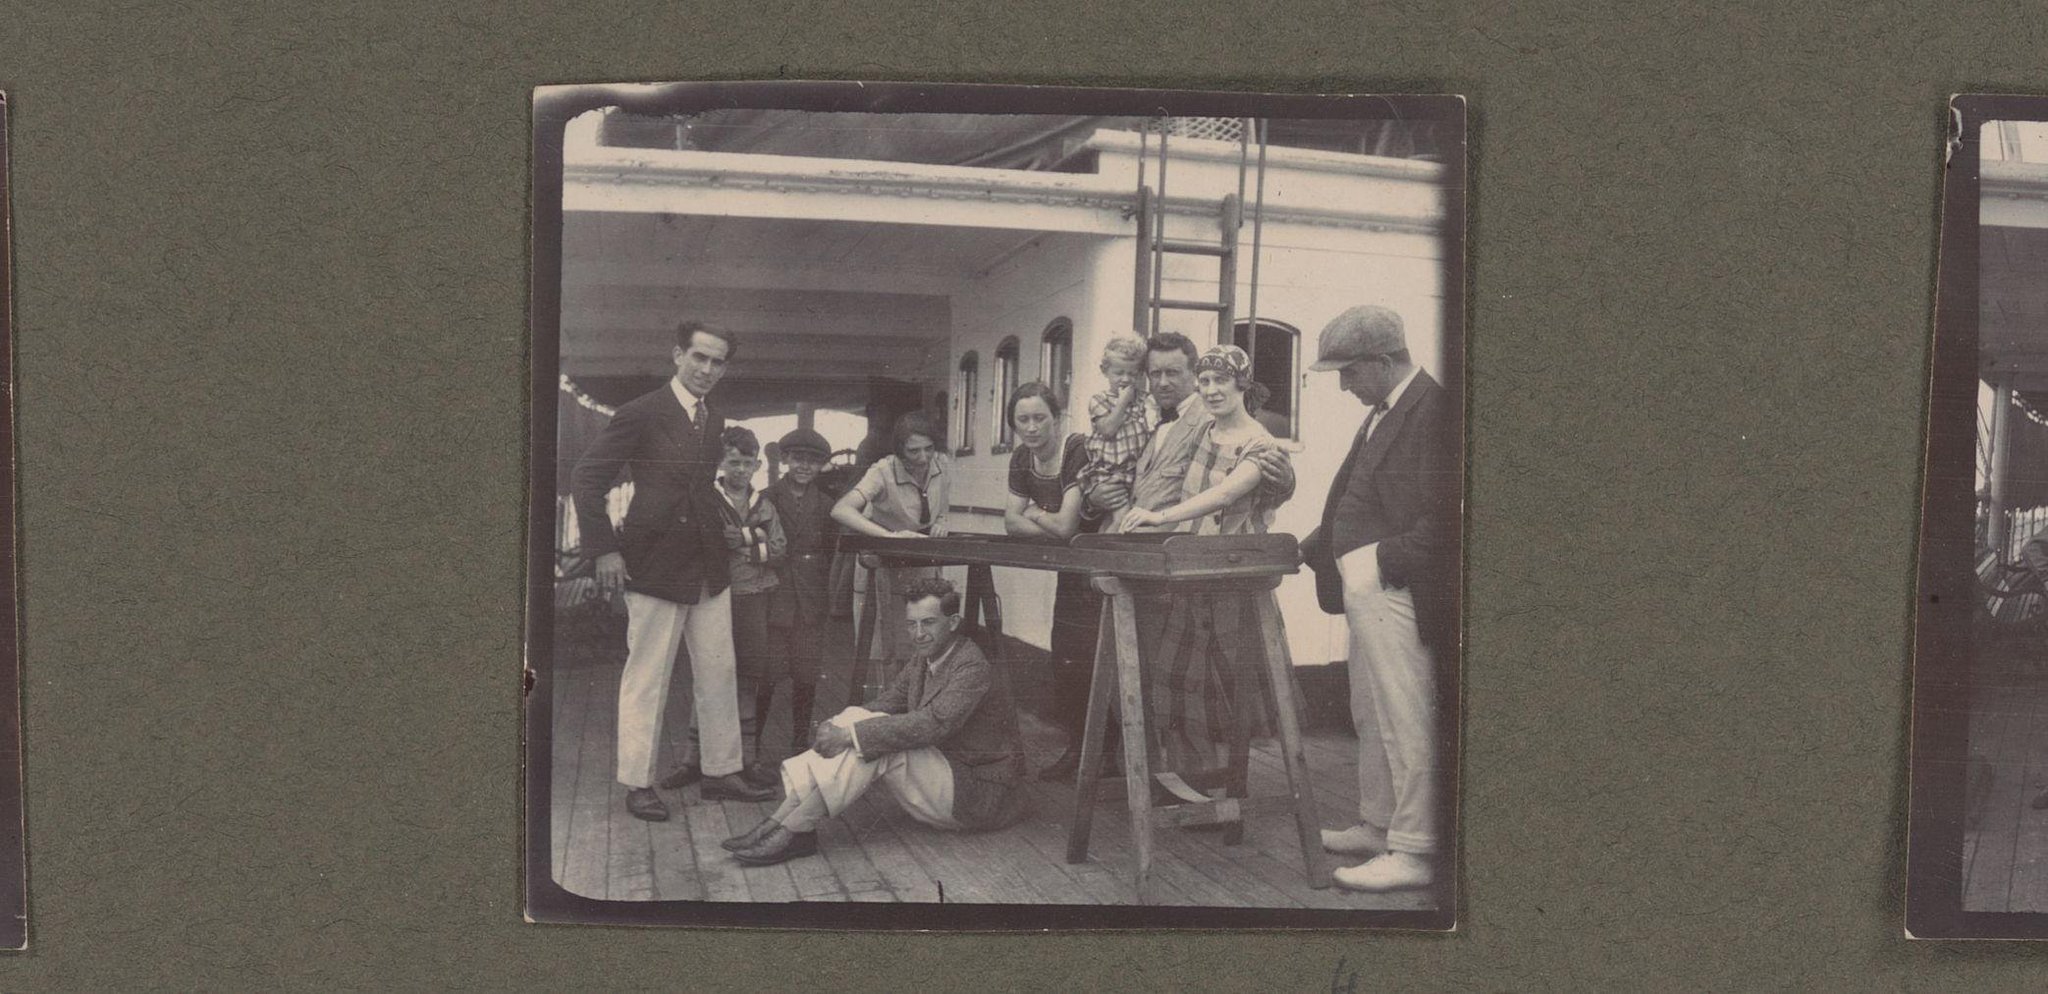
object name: photograph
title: Sjoelen aan dek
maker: Anonymous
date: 1925-1927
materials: photographic support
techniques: photography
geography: suriname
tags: jetten, familie, moengo, madeira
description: Sjoelen aan dek, tijdens bezoek aan Madeira. Foto op een bladzijde van een los albumblad. Onderdeel van het ensemble met foto's van de familie van ingenieur Jetten in de mijnbouwstad Moengo in Suriname.